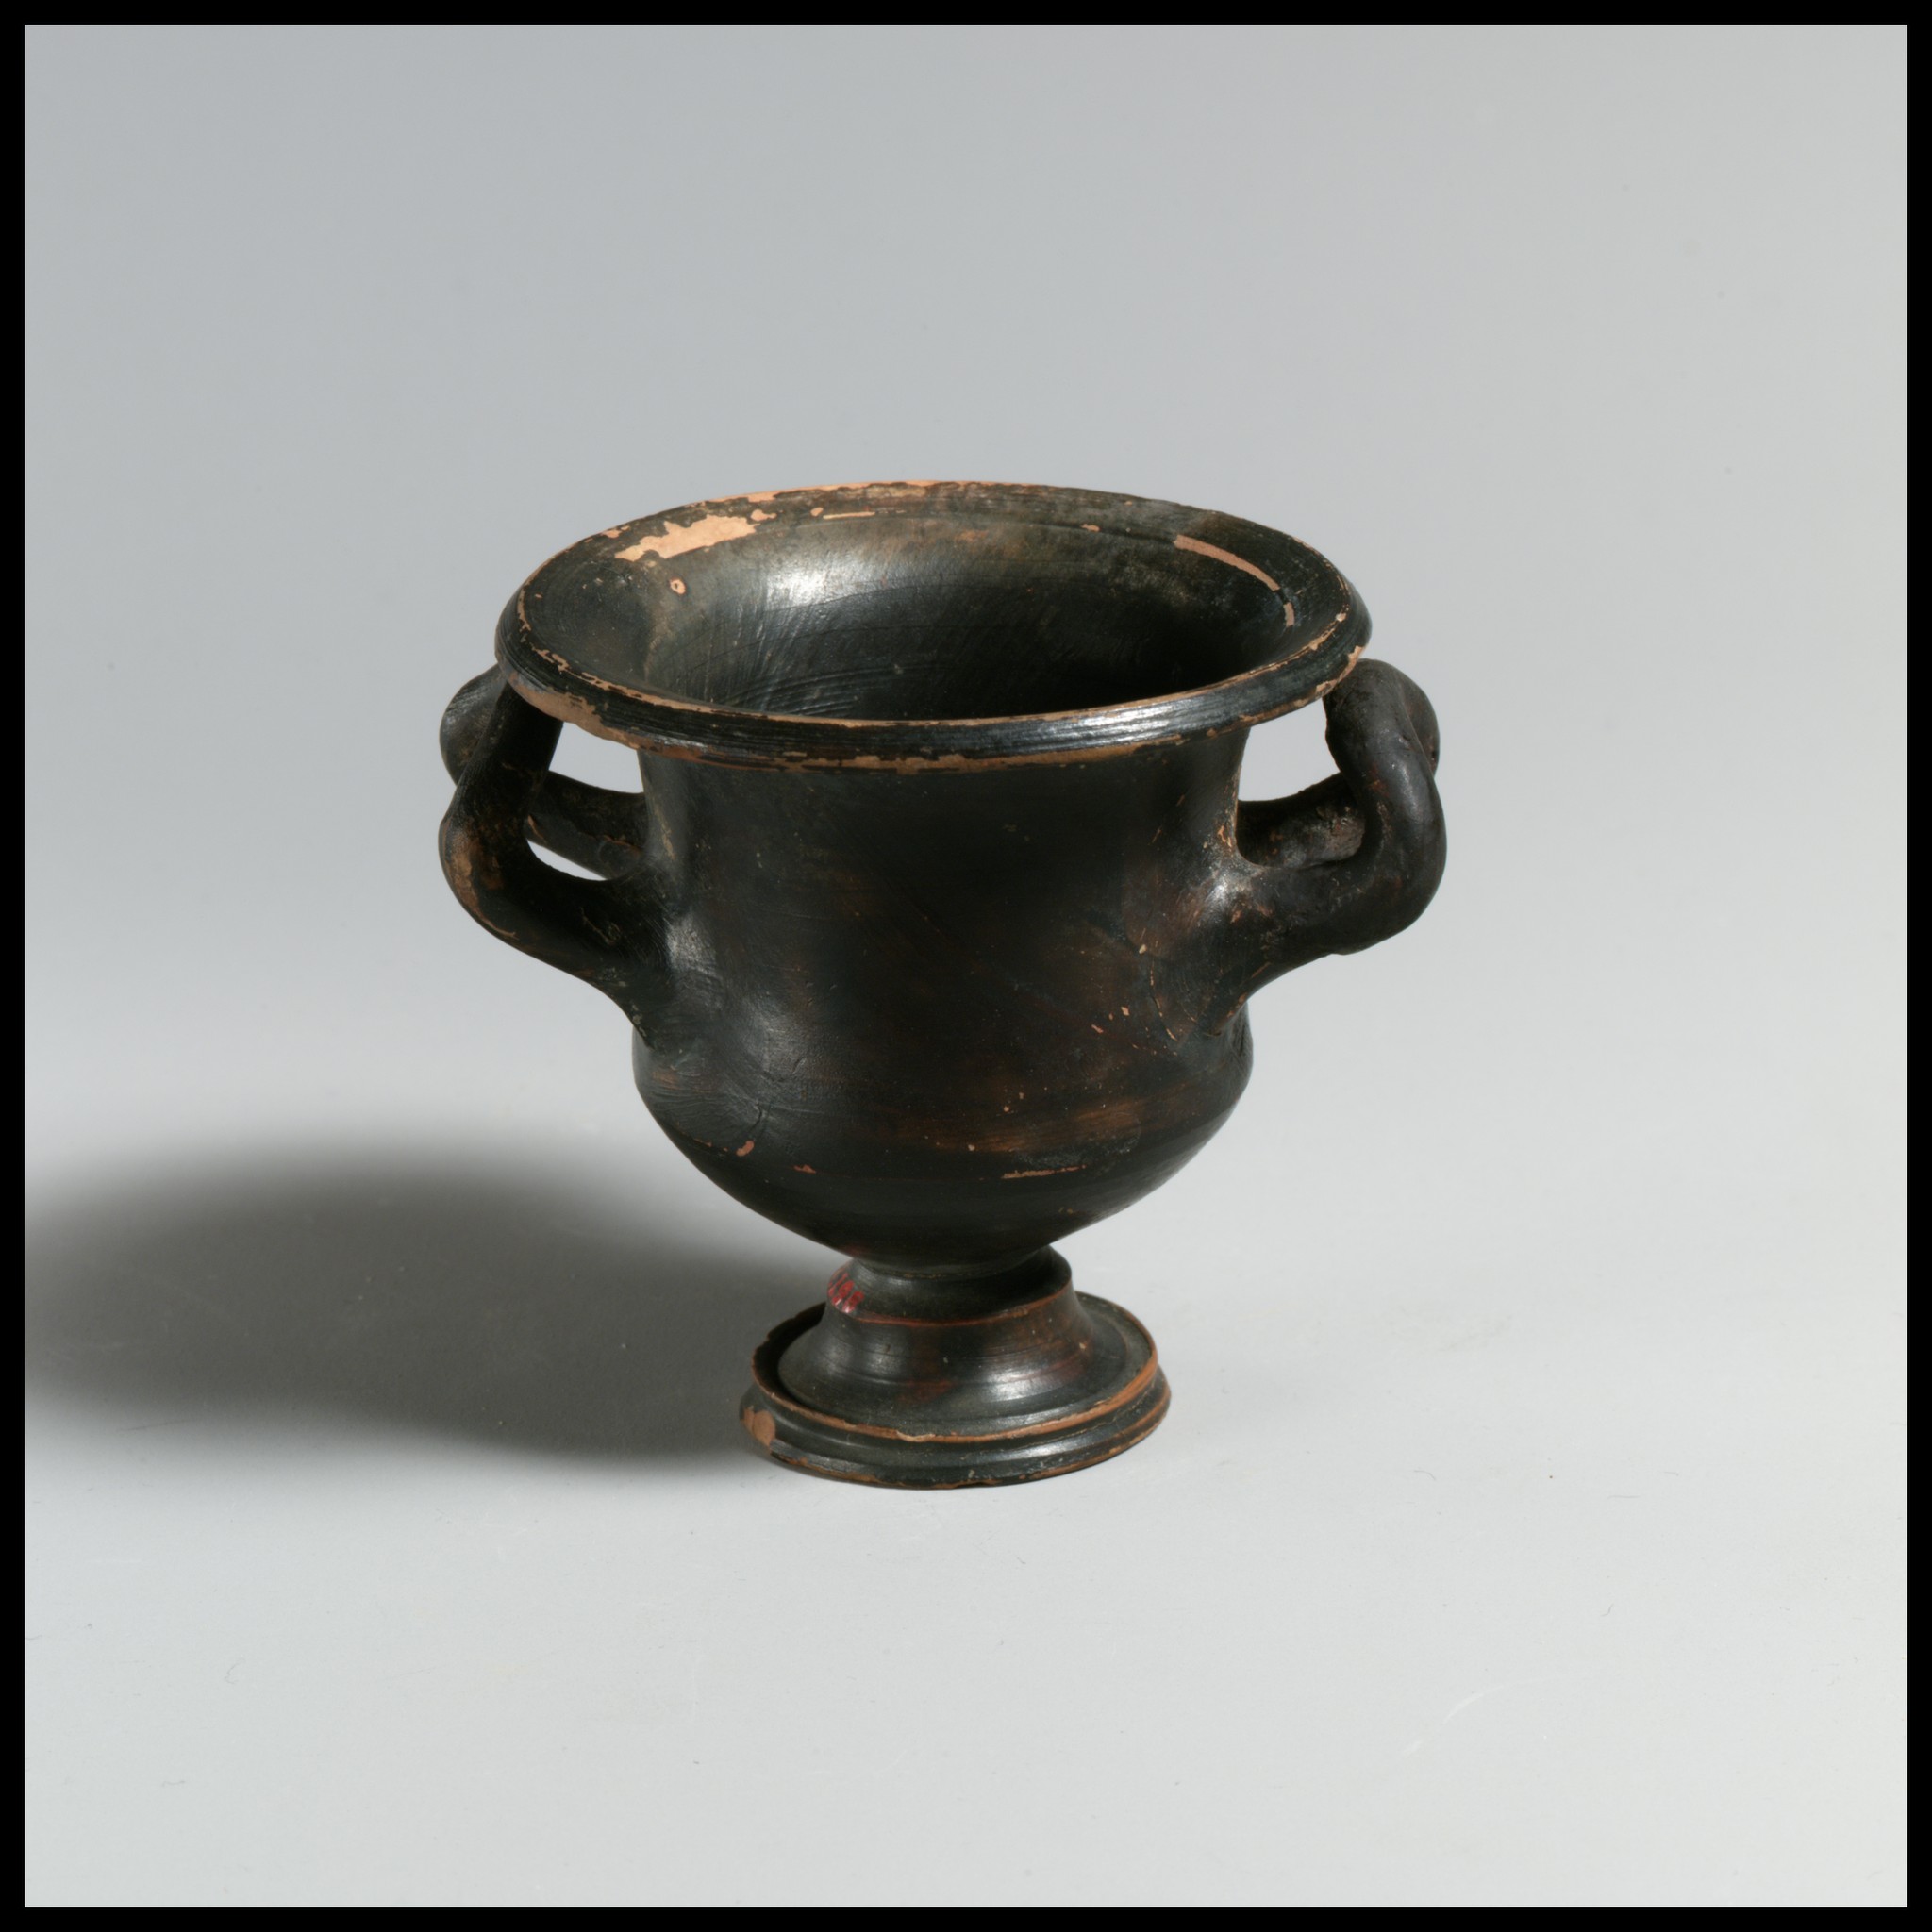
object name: calyx krater, toy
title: Calyx-krater, toy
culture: greek, south italian, apulian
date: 400-301 BCE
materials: terracotta